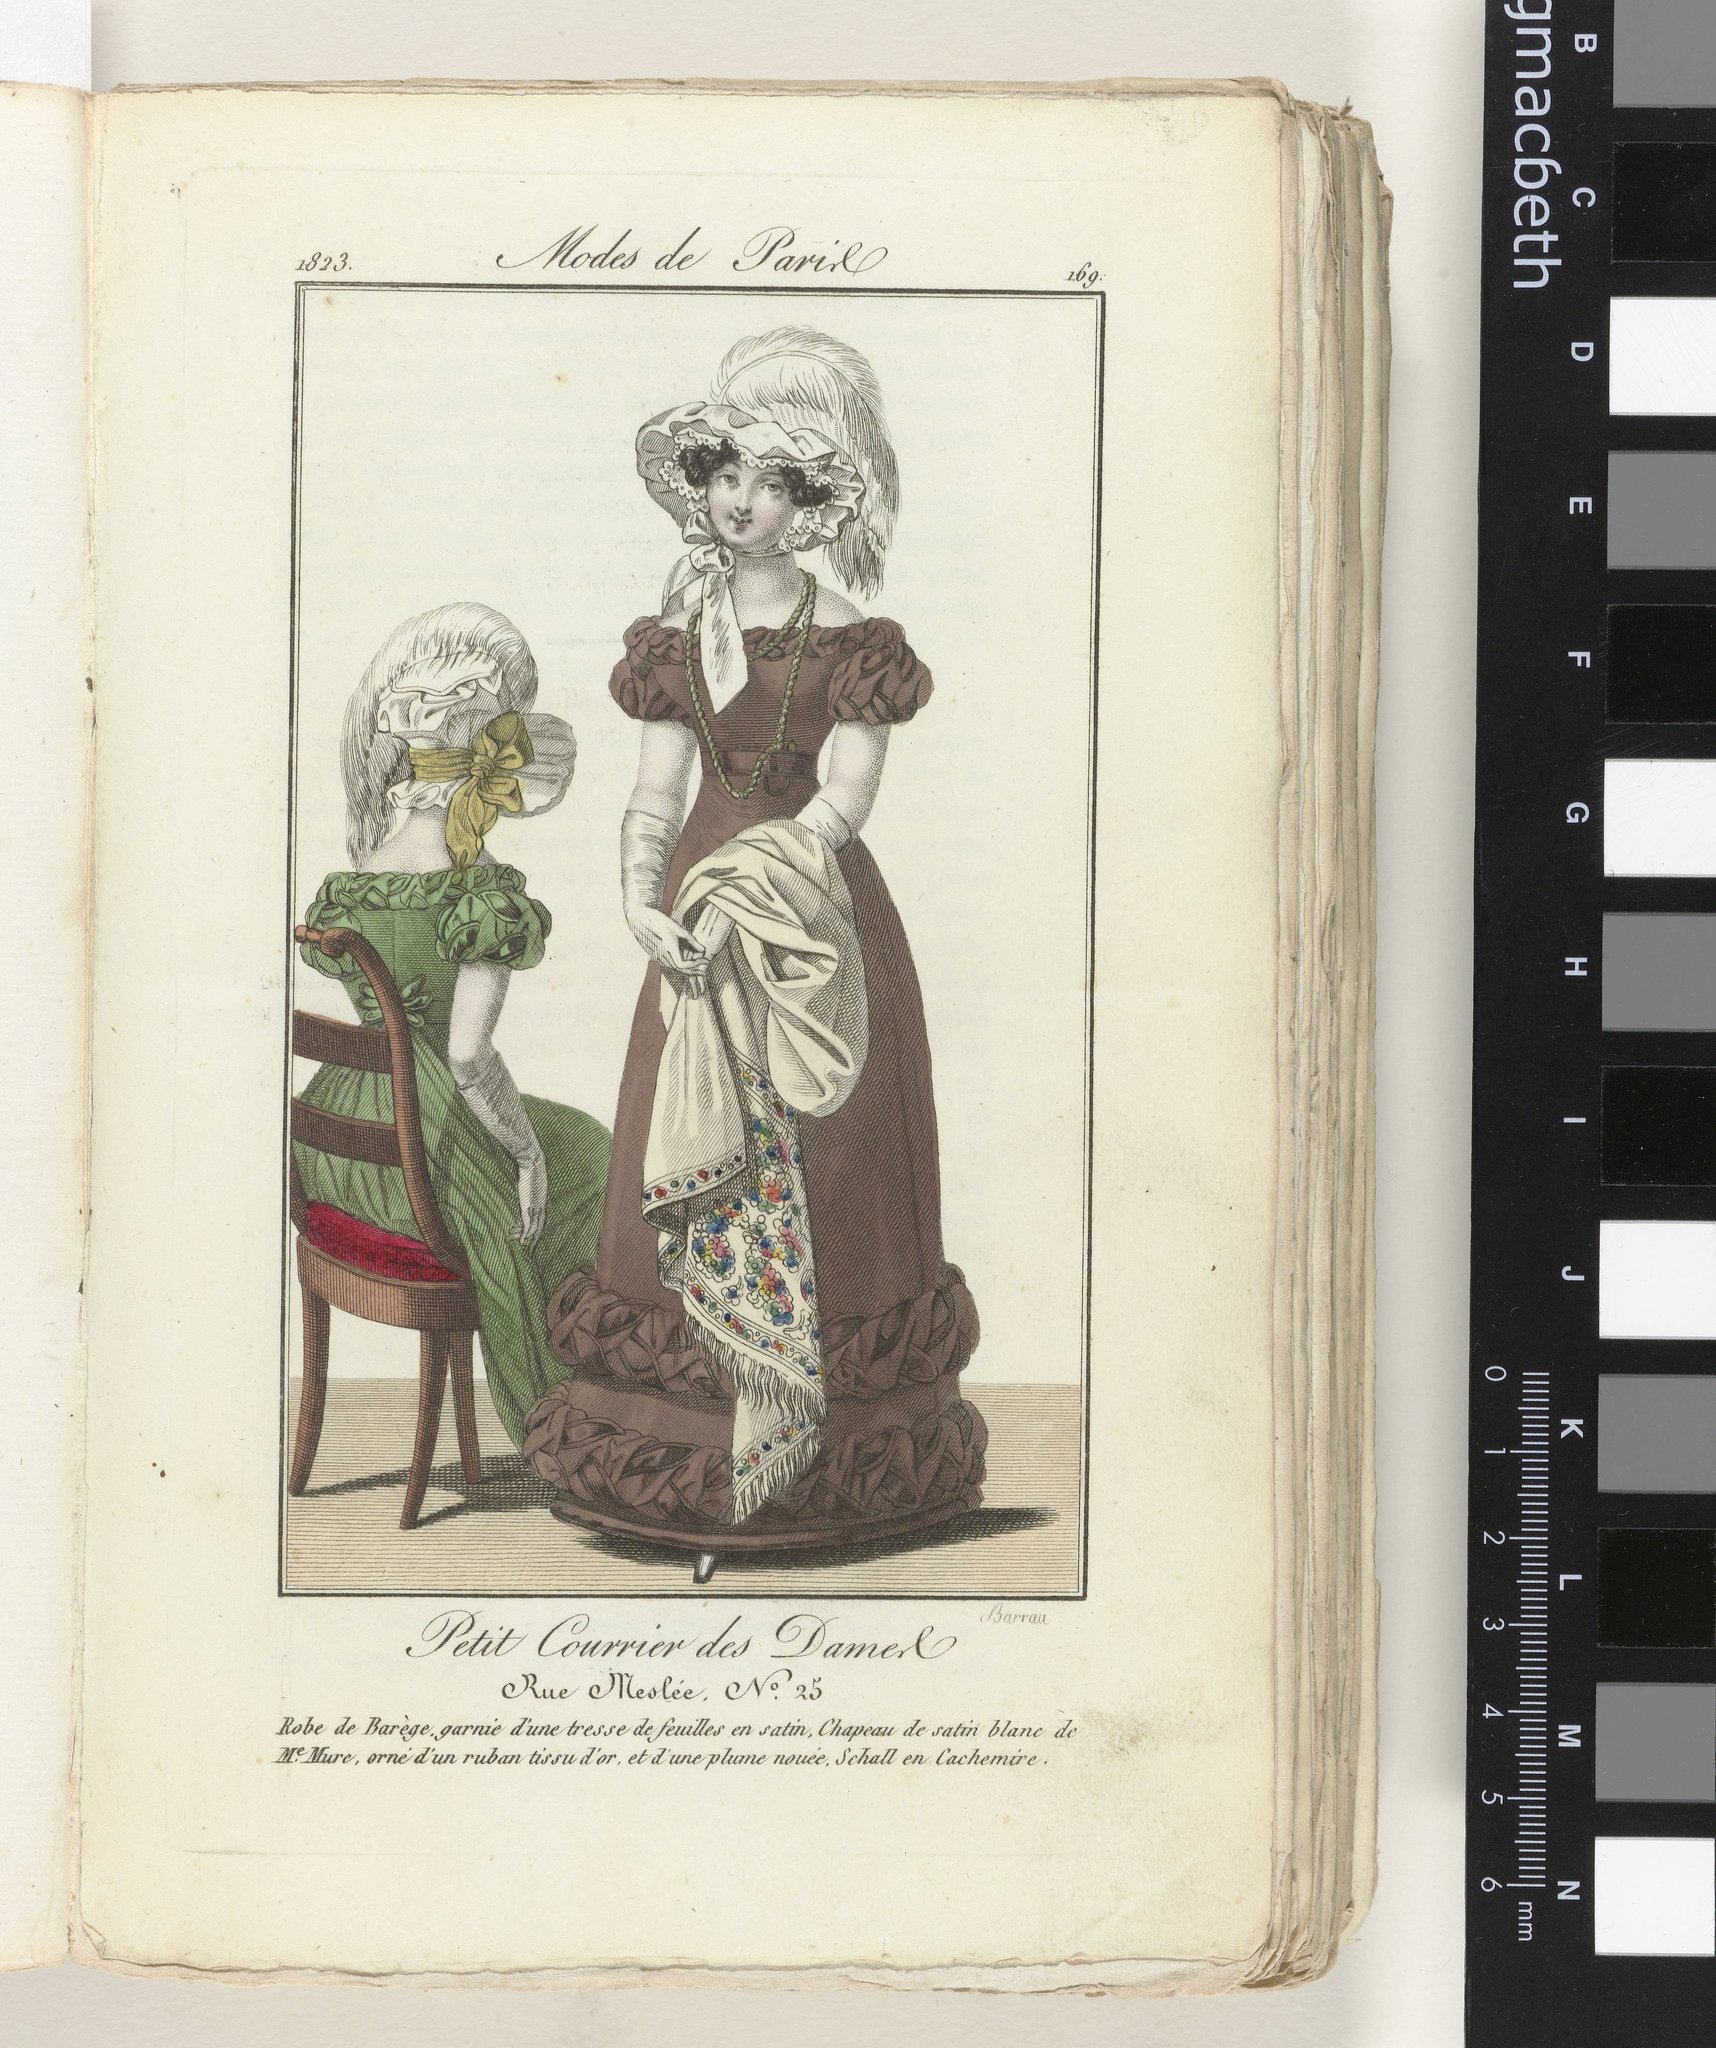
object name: magazine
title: Petit Courrier des Dames 1823 (169)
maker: barrau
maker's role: print maker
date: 1823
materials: paper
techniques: engraving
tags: fashion plates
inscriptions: date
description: Prent uit het modetijdschrift Petit Courrier des Dames (1821-1868).